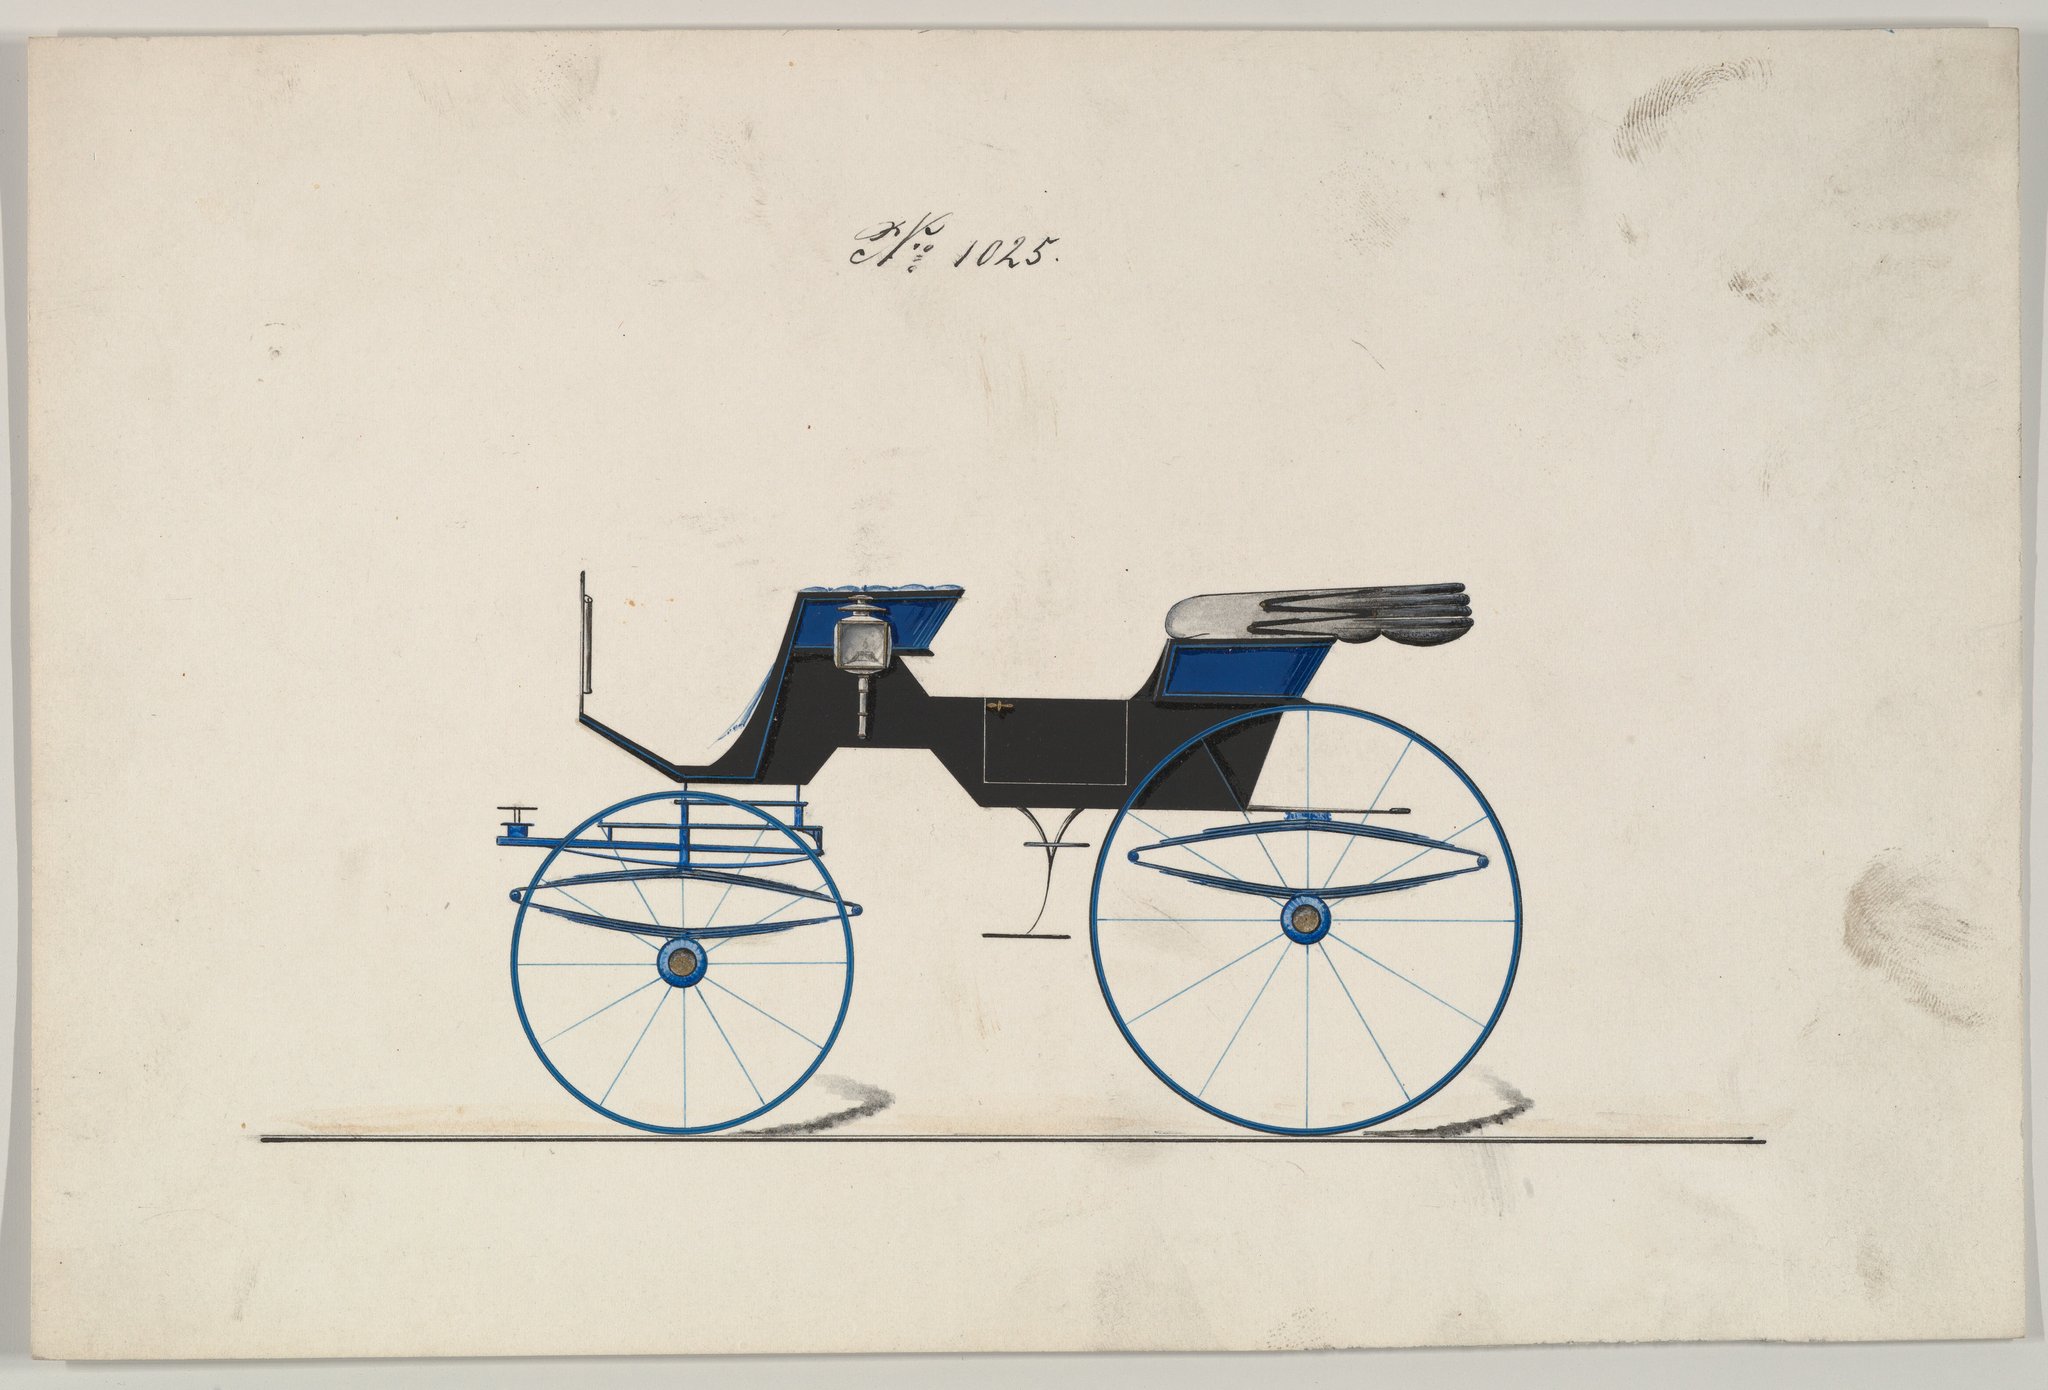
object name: drawing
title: Design for Phaeton, no. 1025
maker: brewster & co.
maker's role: manufacturer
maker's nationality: american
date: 1850-1874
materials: gouache, gum arabic, watercolor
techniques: pen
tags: carriages